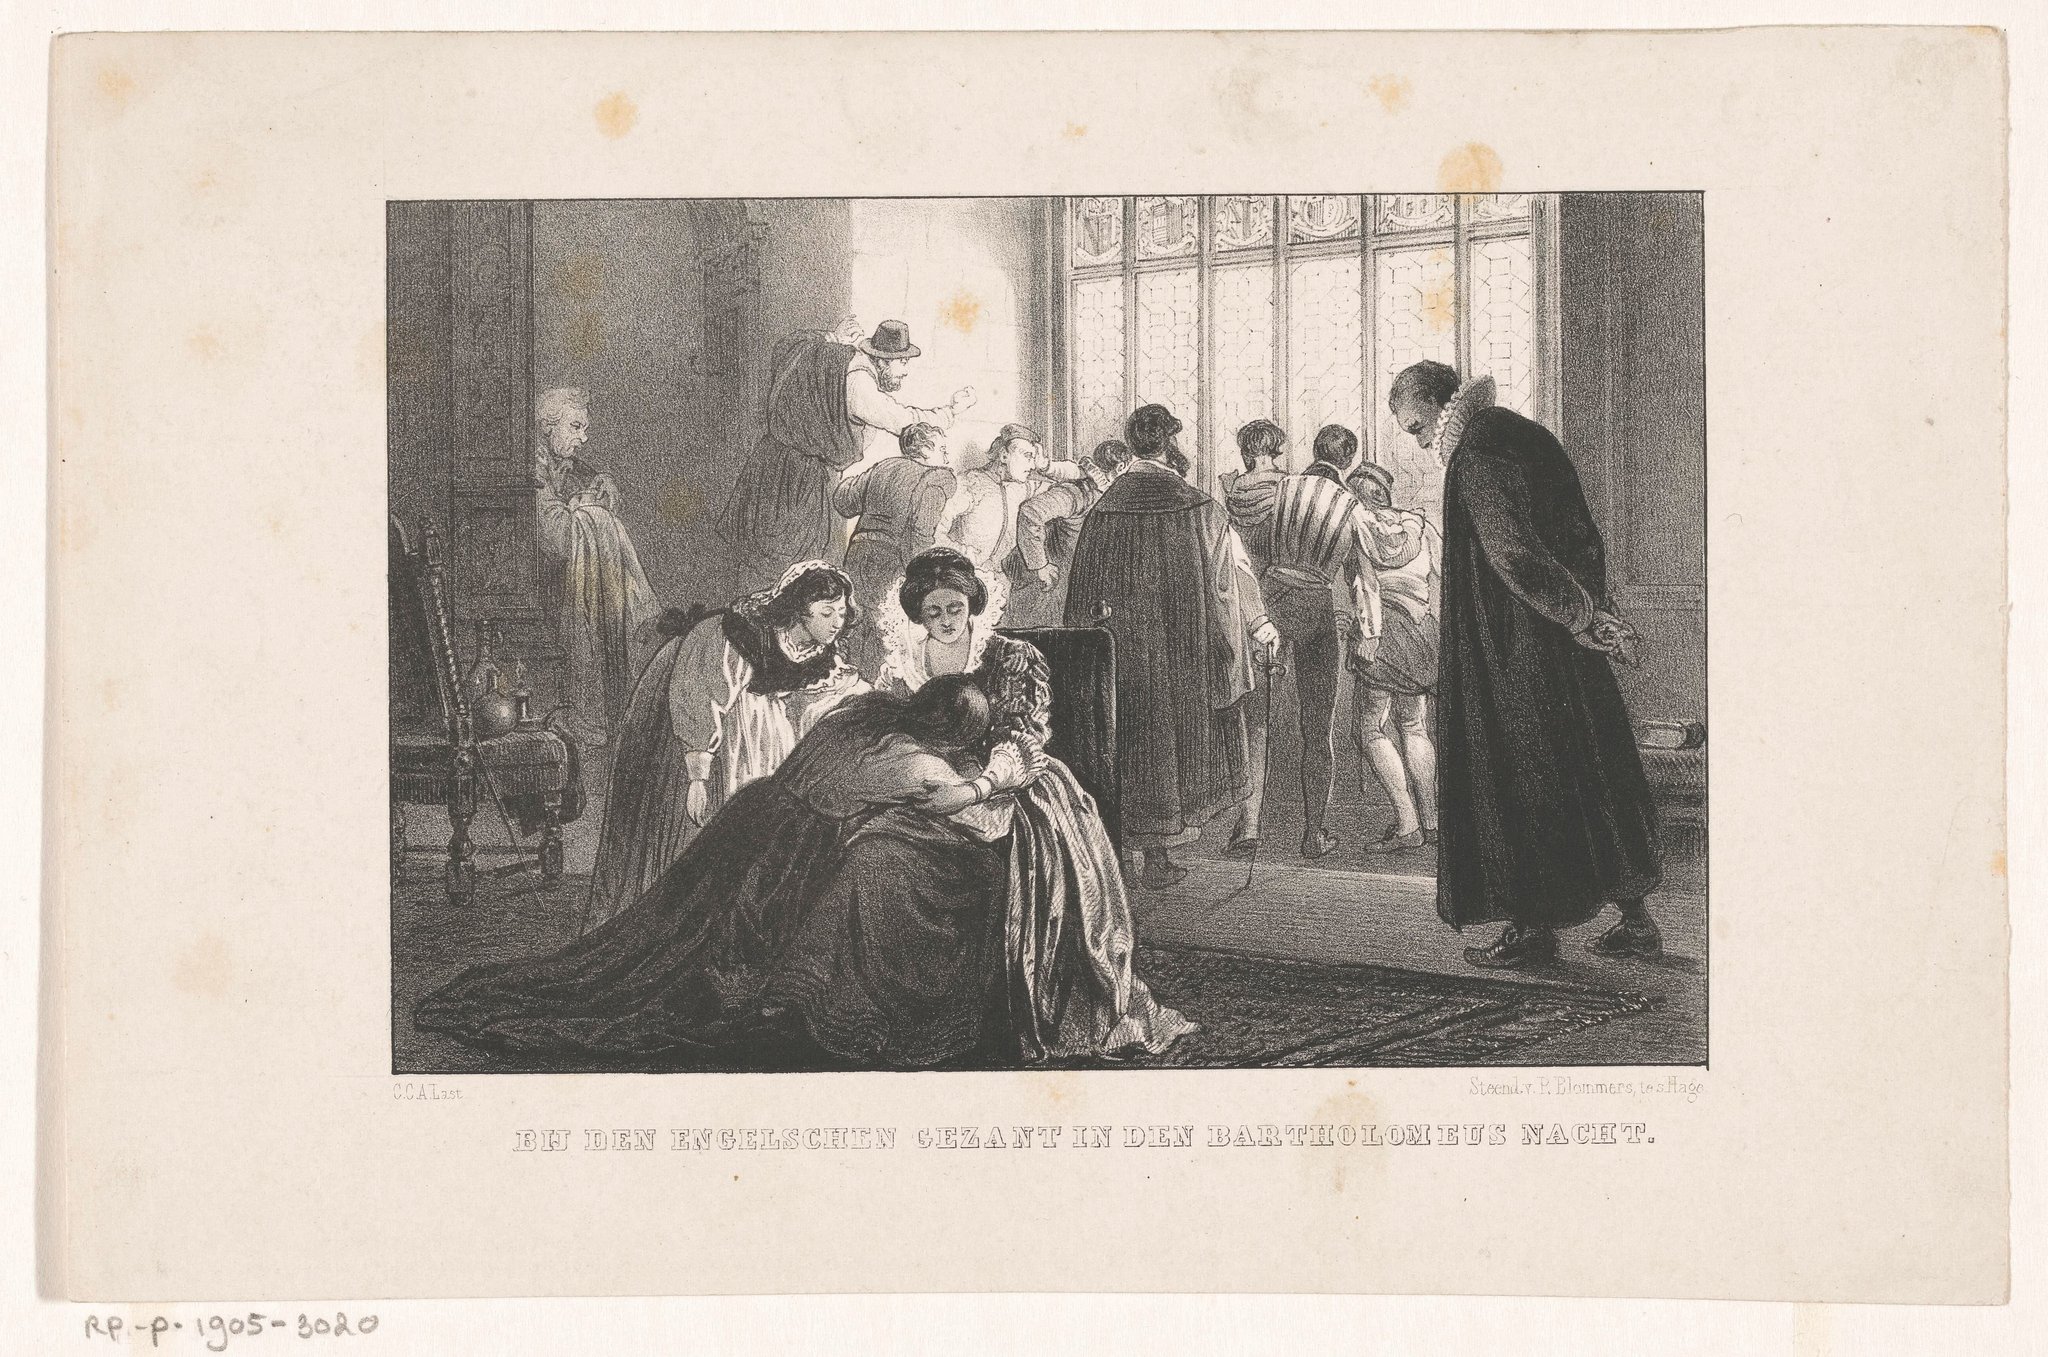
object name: print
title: By den Engelschen gezant in den Bartholomeus nacht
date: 1842-1887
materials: paper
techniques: lithograph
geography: the hague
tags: communal rooms, weeping, human figure at (open) window, seen from inside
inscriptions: collector's mark: Lugt 2228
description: In een interieur drommen mannen voor het raam om naar buiten te kijken. In de voorgrond drie vrouwen. Een van hen huilt in de schoot van een ander.